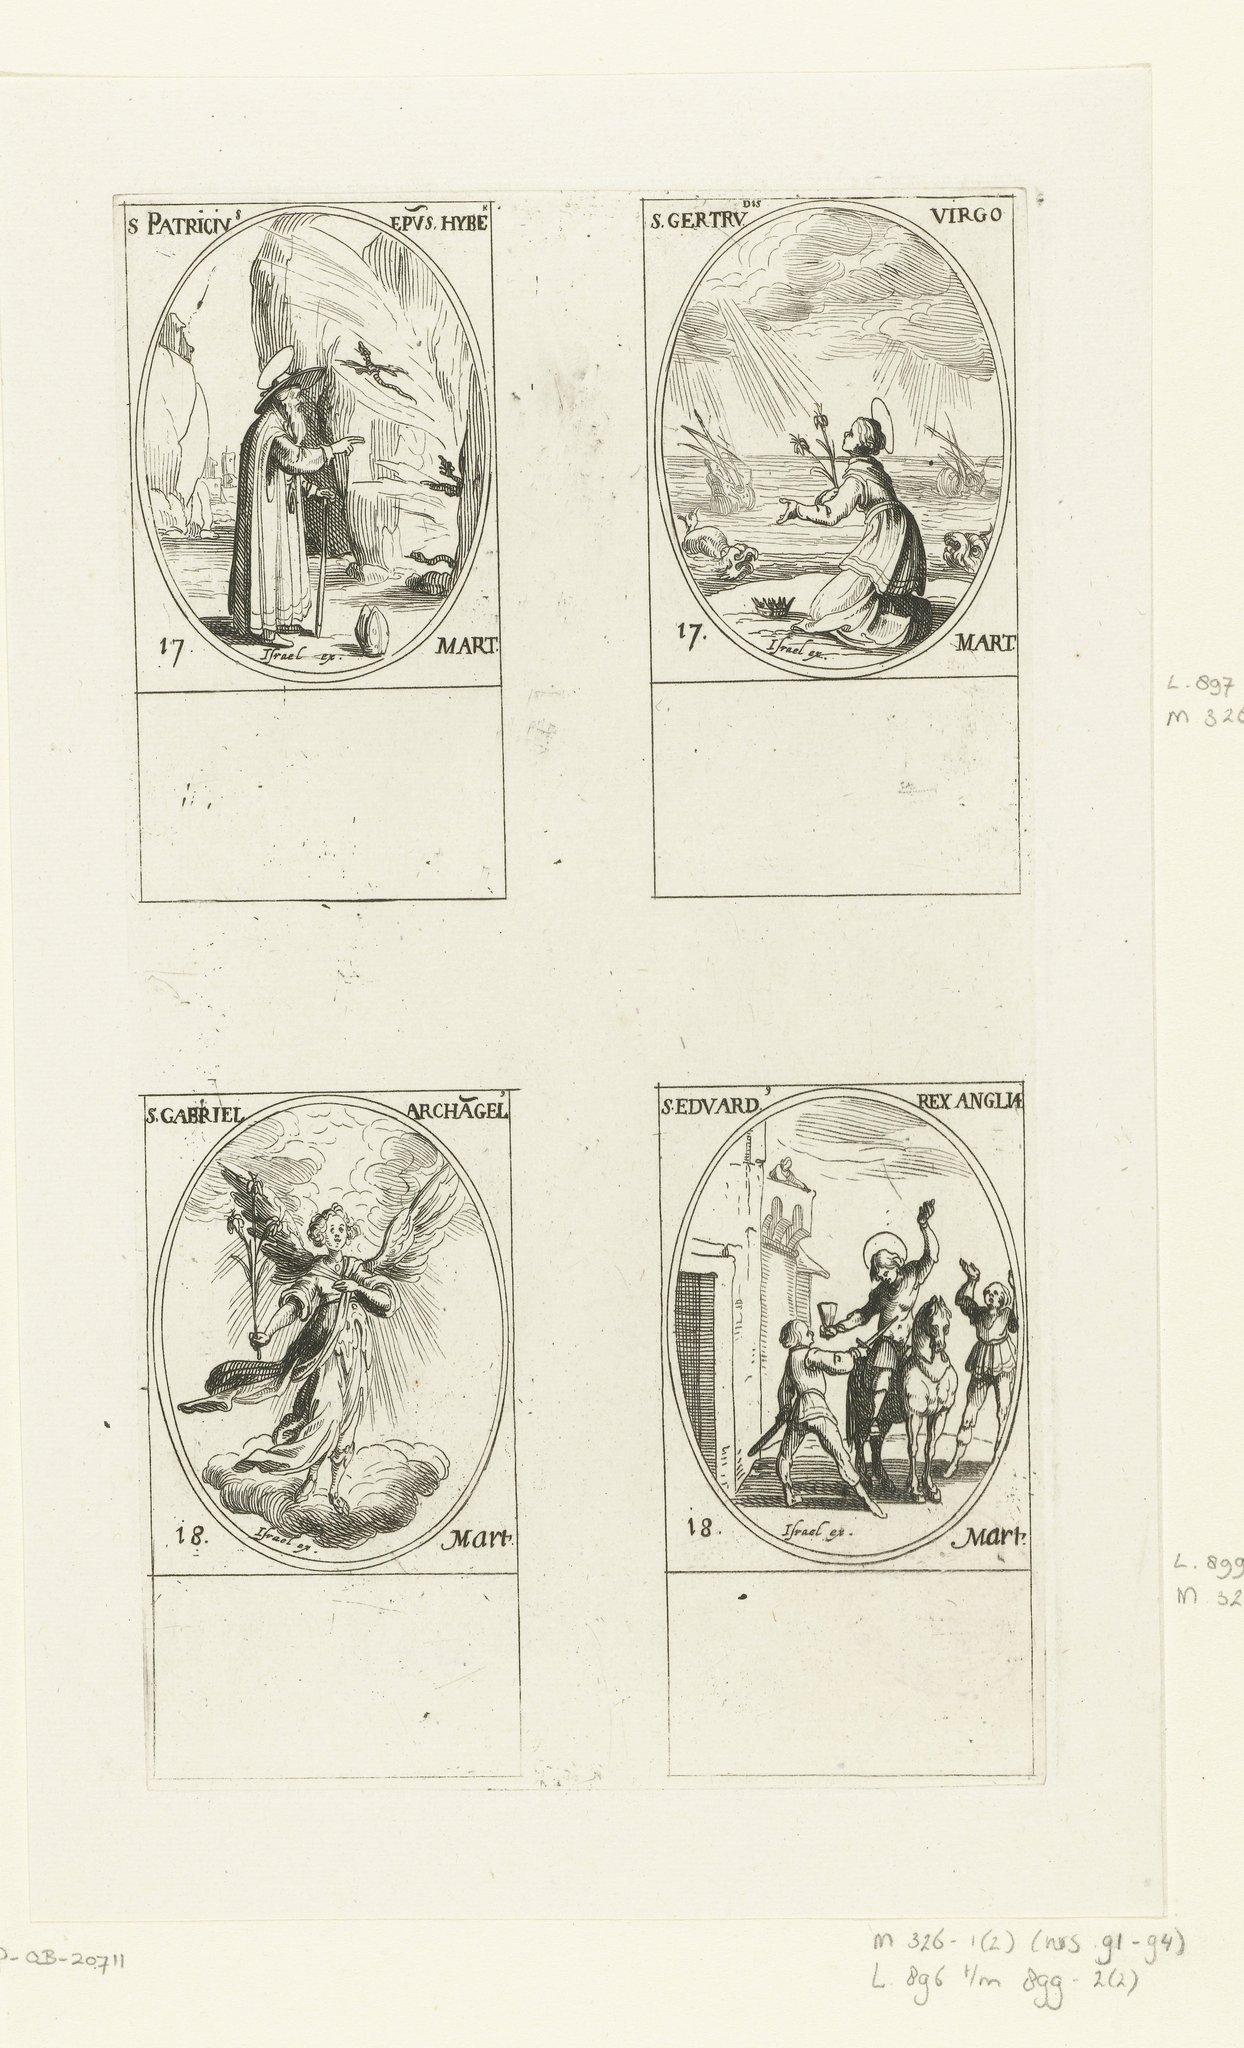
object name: print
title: Alle heiligen en de Christelijke feestdagen van het jaar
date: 1632-1636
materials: paper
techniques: etching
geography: paris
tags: the archangel gabriel, the abbess gertrude of nivelles; possible attributes: book, pastoral staff, crown, cup, demon, mouse or mice, model of church or hospital, palm, (healing) well, male saints (with name)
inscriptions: collector's mark: Lugt 240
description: Blad met vier ovale voorstellingen, elk met opschrift en datum in het Latijn: linksboven de Heilige Patricius bij een opening in een rots waaruit vuur en demonen komen, rechtsboven de Heilige Gertrudis knielend aan een kust, linksonder de aartsengel Gabriël met een lelie in de hand, rechtsonder de Heilige Eduard de Martelaar (Edward the Martyr) te paard die wordt doorgestoken. Deze prent is onderdeel van een serie prenten met voorstellingen van de heiligen en de christelijke feestdagen van het jaar. Er zijn steeds vier scènes van één plaat op één blad gedrukt. Inclusief bijbehorend titelblad en frontispice gaat het in totaal om 124 platen (490 voorstellingen). De drie platen met de laatste 12 scènes (de veranderlijke christelijke feestdagen) zijn in de derde staat versneden tot 12 kleine plaatjes, en met een apart titelblad uitgegeven.